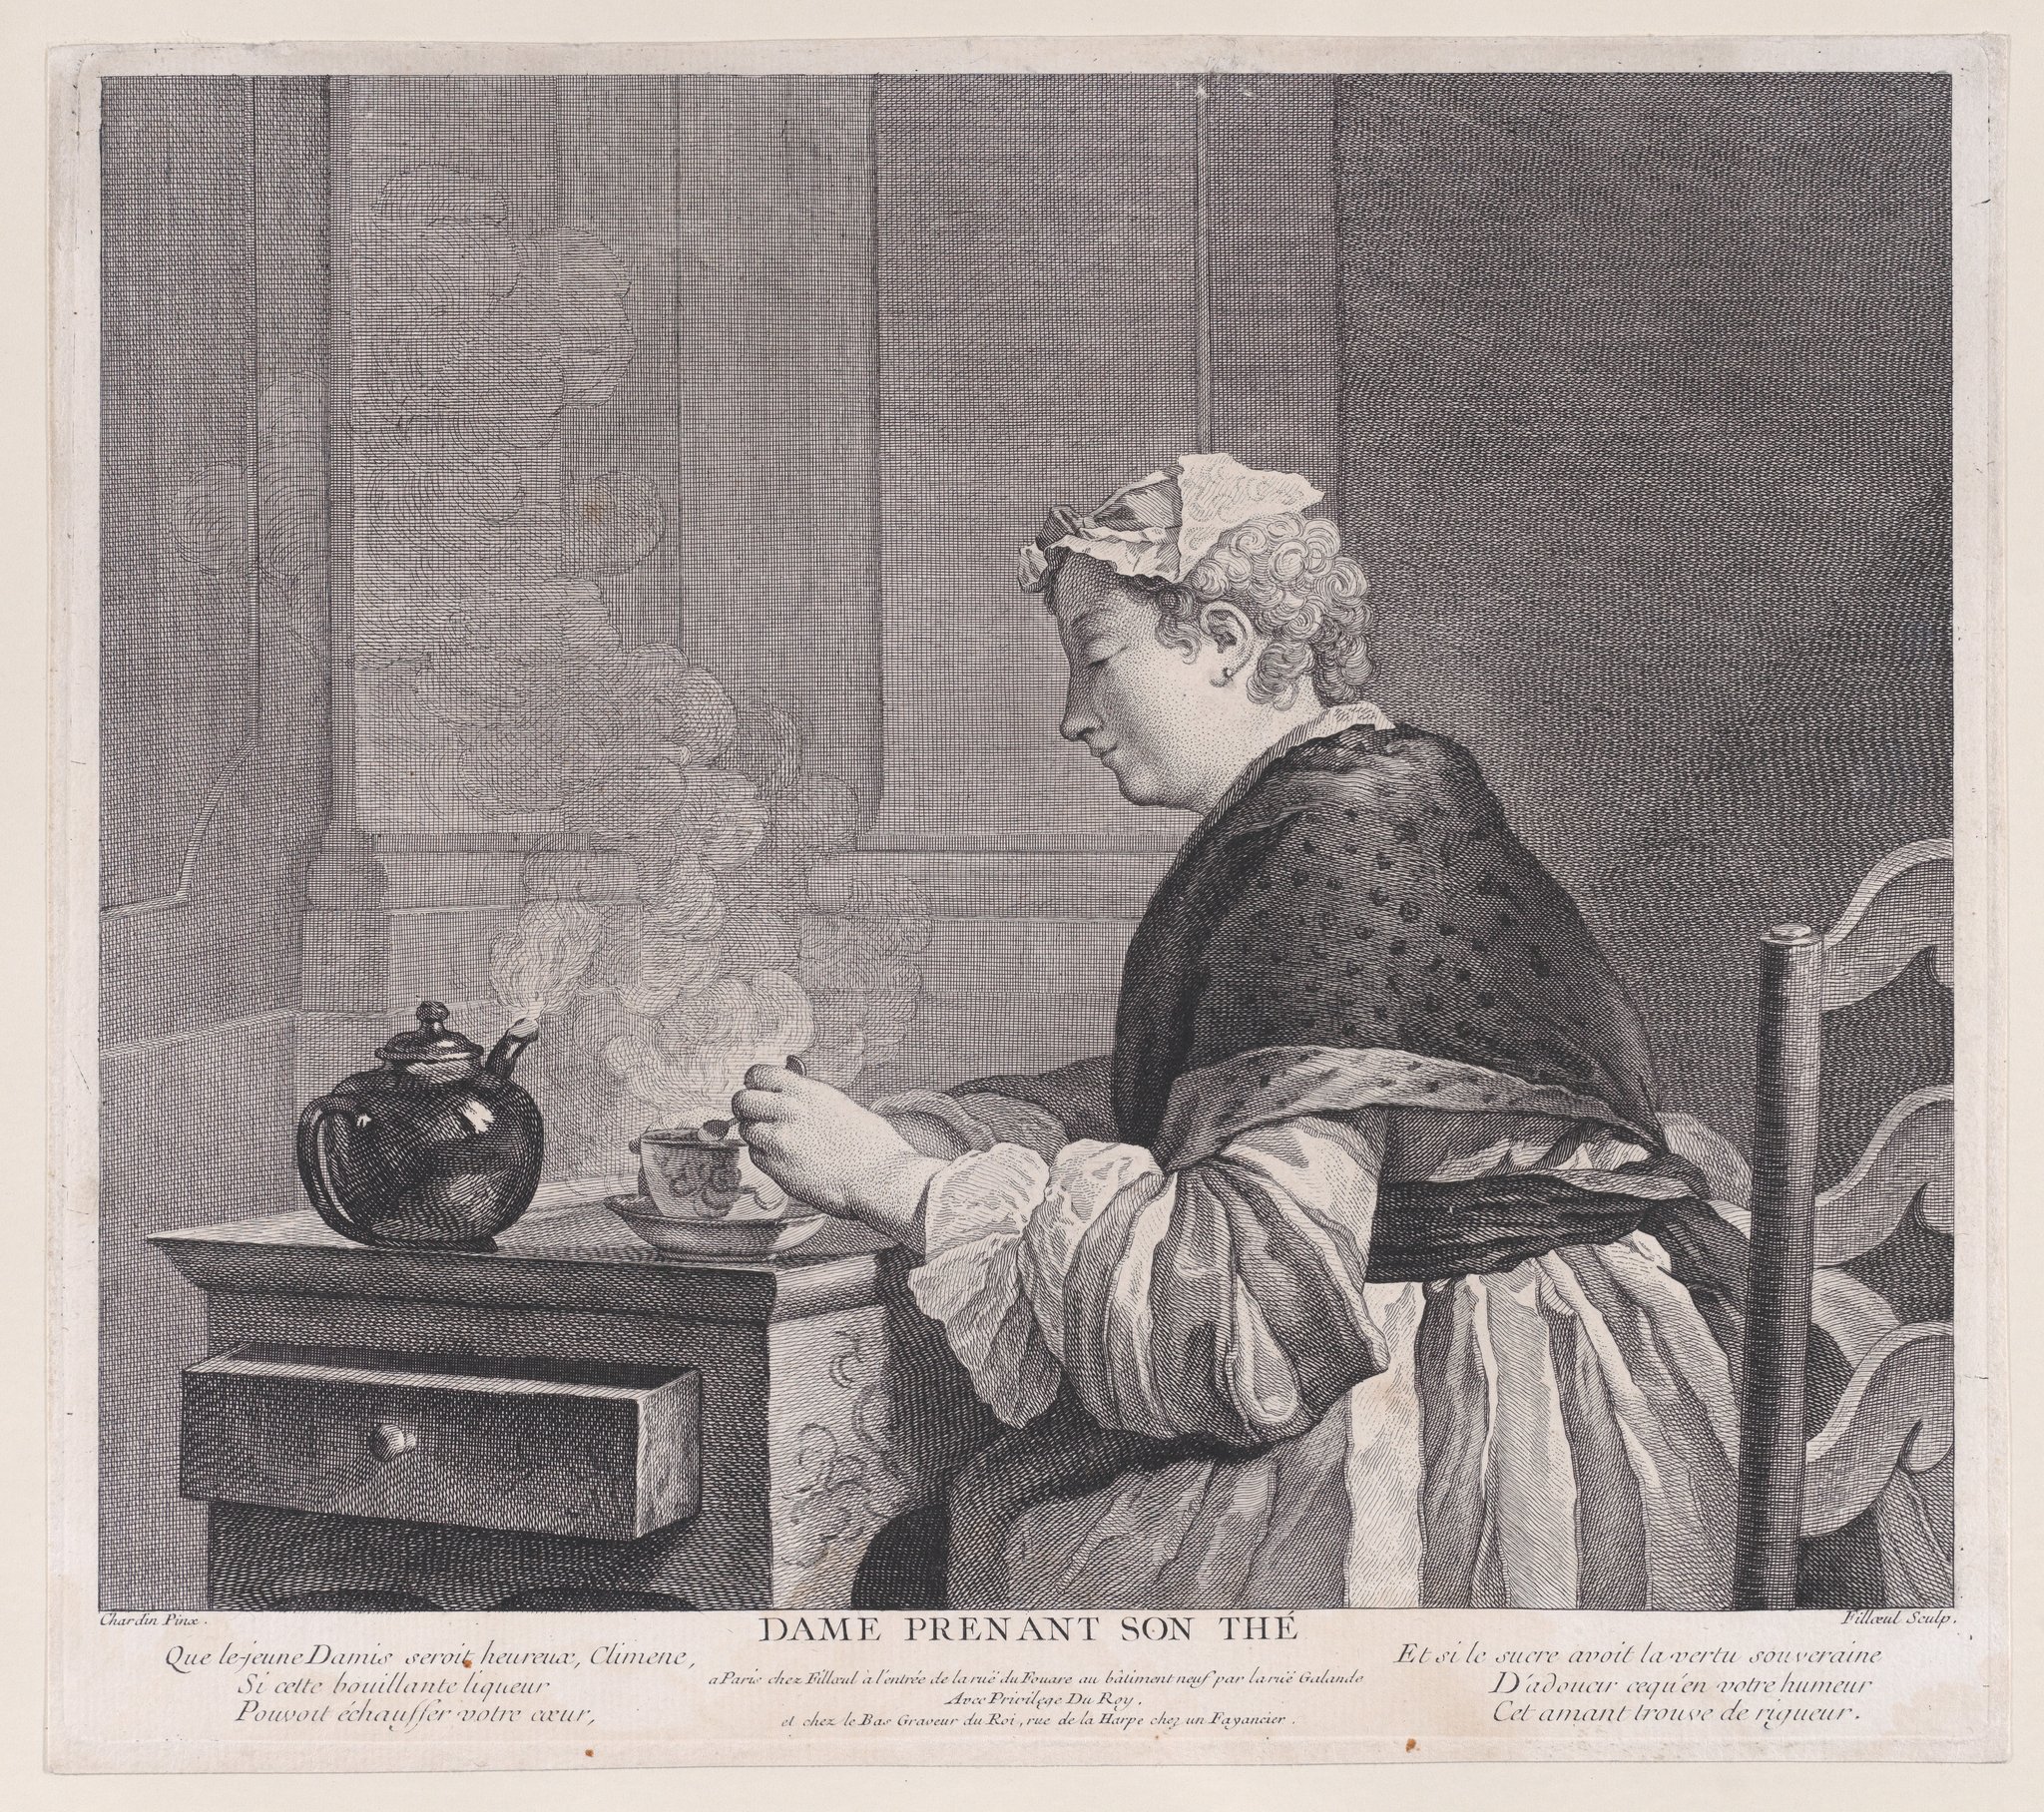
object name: print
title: Woman Taking Her Tea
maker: pierre filloeul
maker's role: artist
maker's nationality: french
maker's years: 1696-1754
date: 1759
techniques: engraving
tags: women,tea drinking